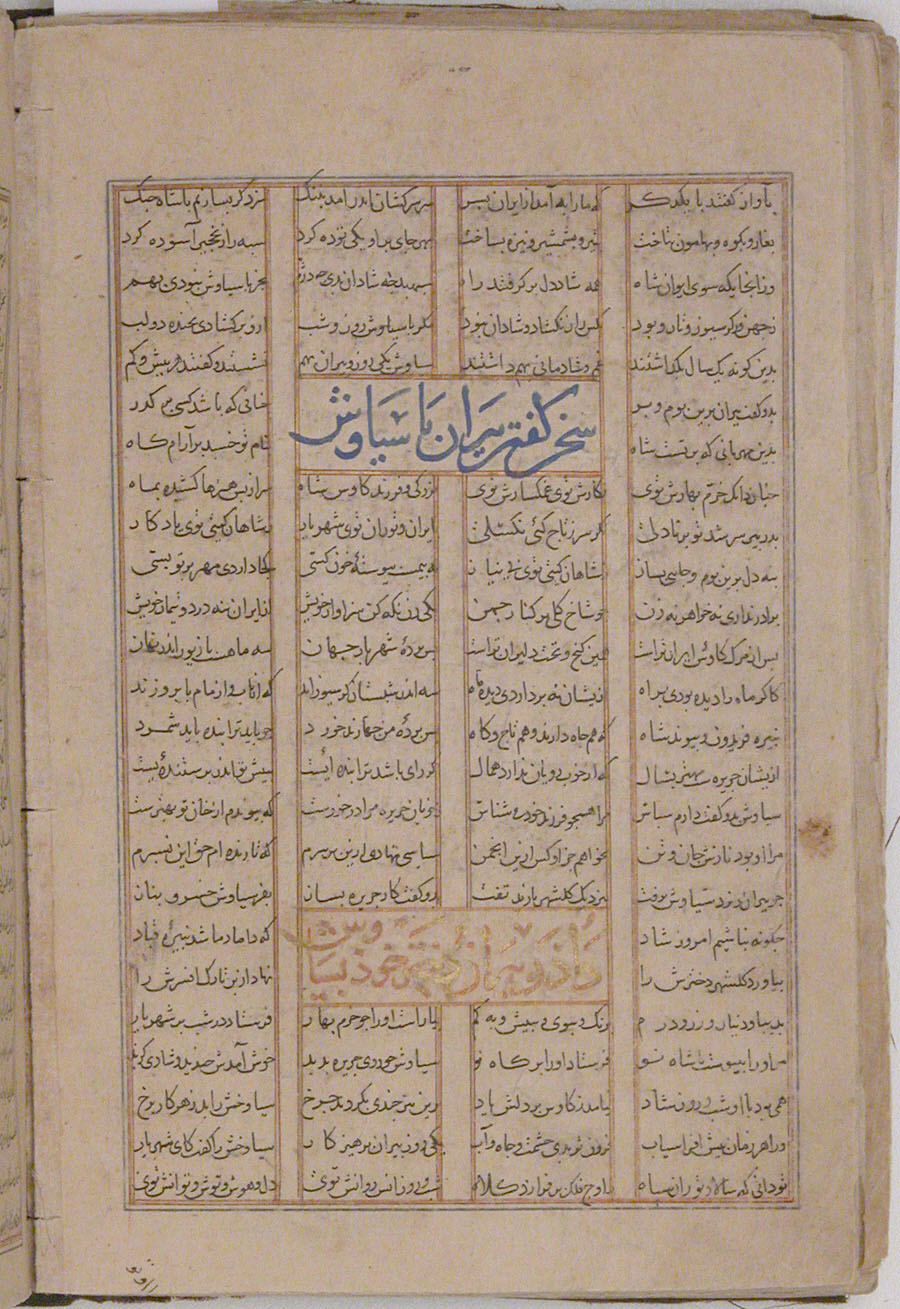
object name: illustrated manuscript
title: Page of Calligraphy from a Shahnama (Book of Kings)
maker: abu'l qasim firdausi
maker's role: author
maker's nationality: iranian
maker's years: 935-1020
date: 1330-1340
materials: textile, gold, ink, paper, silver, watercolor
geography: iran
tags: calligraphy